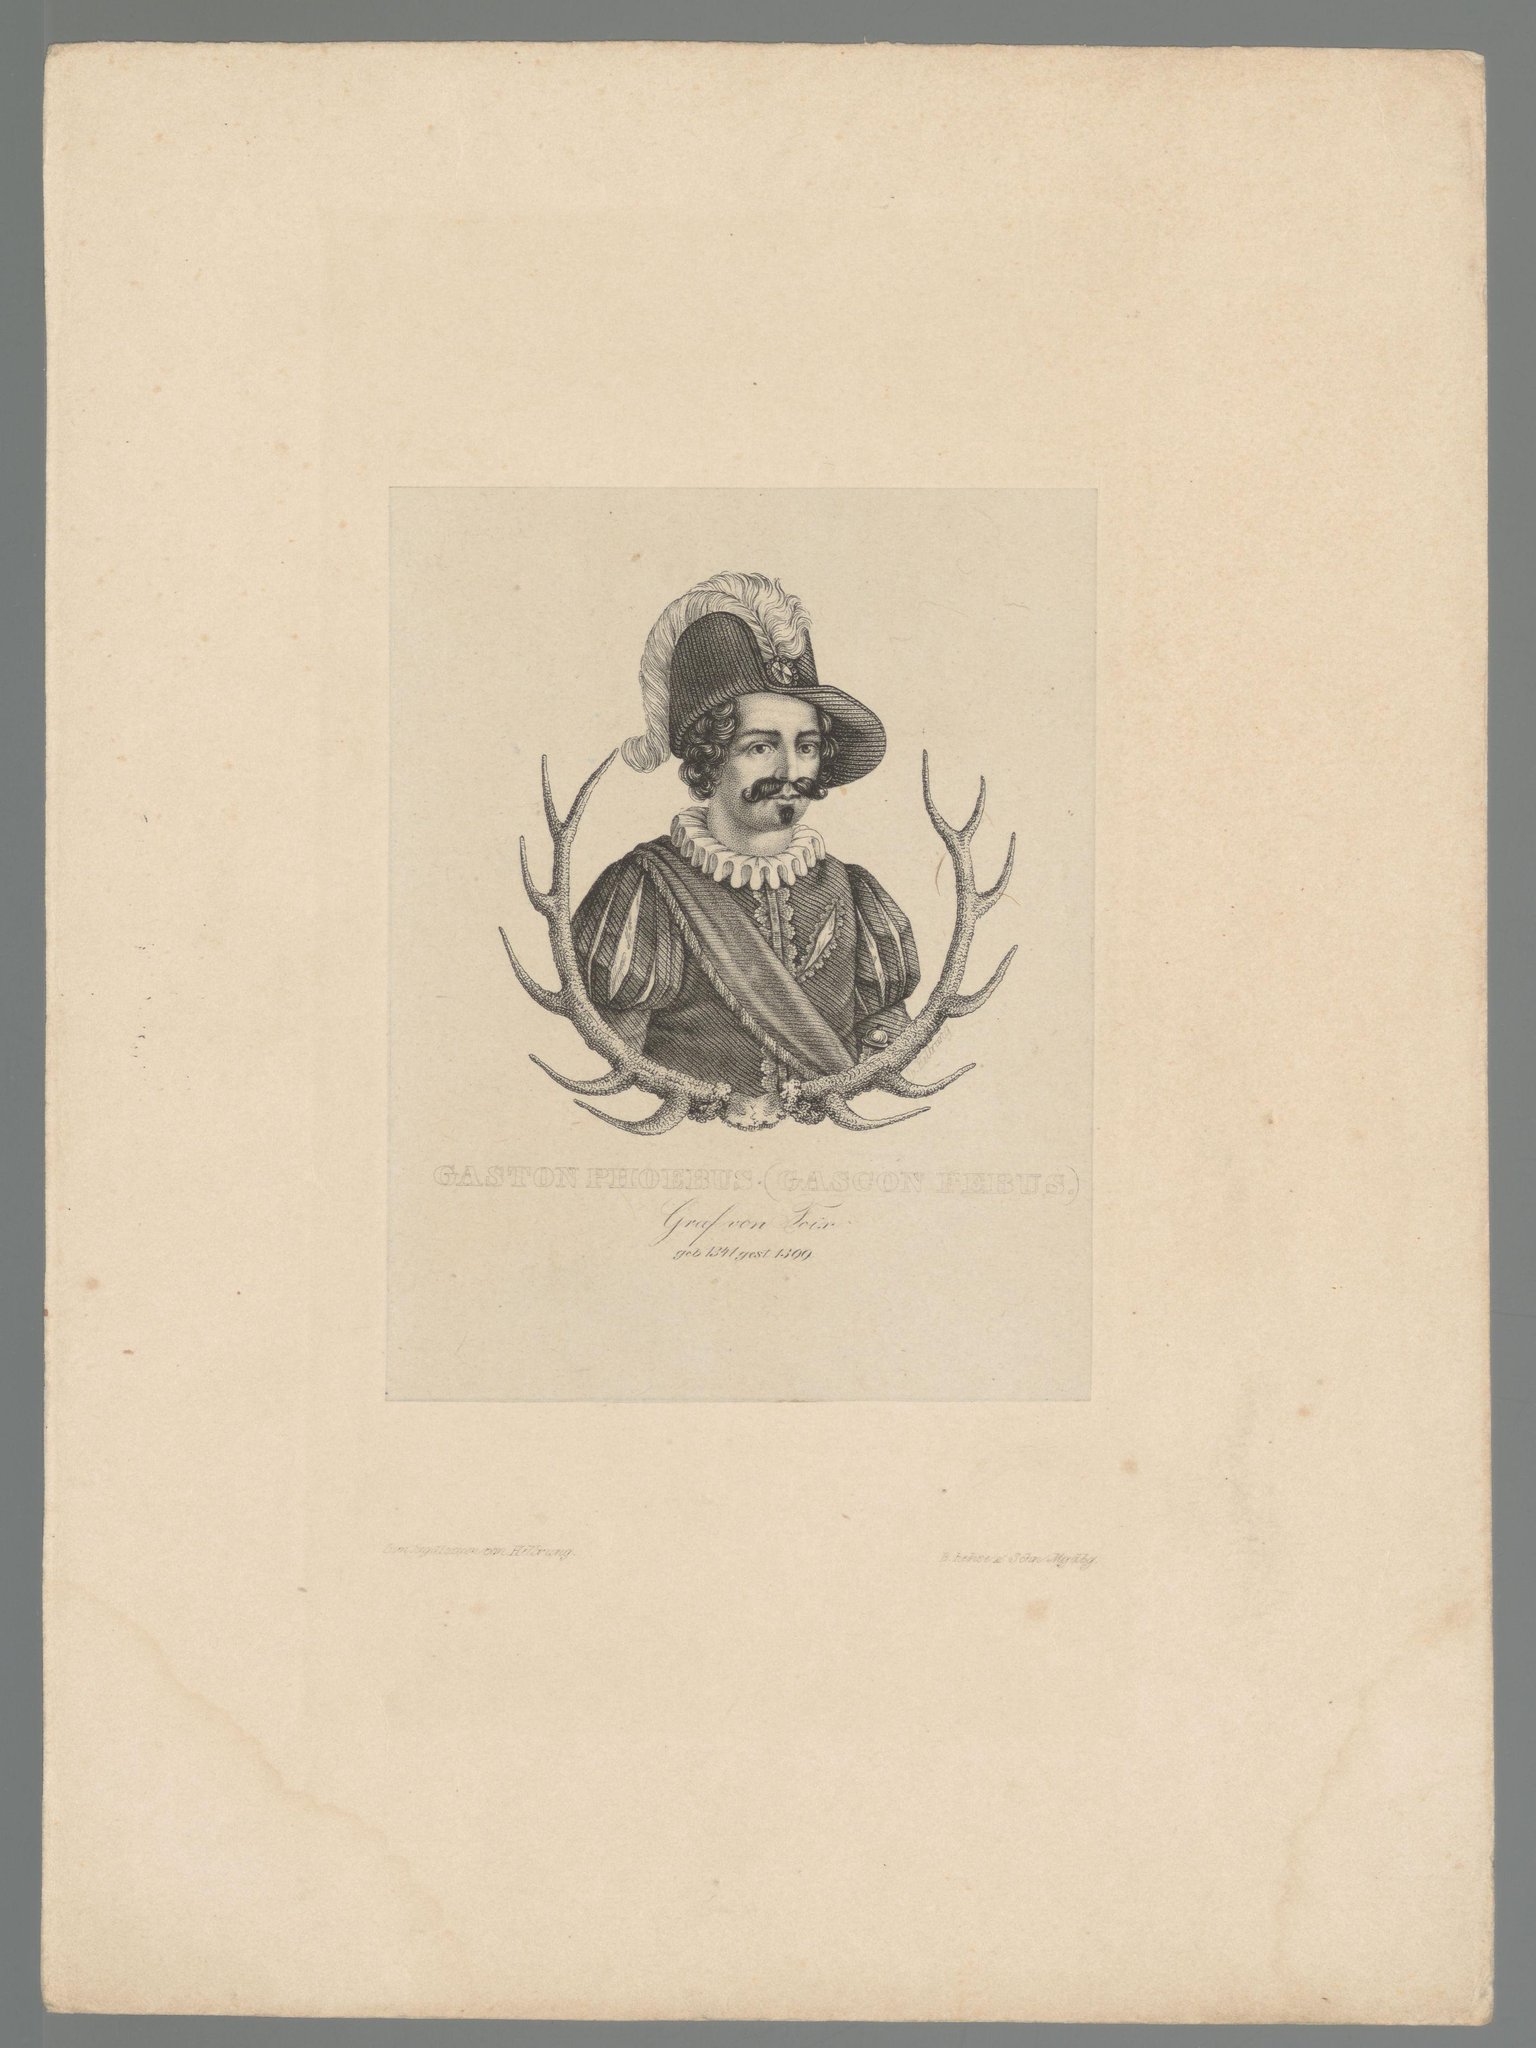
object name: print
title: Gaston Phoebus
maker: carl ludwig hellrung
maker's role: draughtsman, print maker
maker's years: 1794-1851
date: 1809-1851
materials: paper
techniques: lithograph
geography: magdeburg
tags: earl, historical persons, ruler, sovereign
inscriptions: collector's mark: Lugt 2228